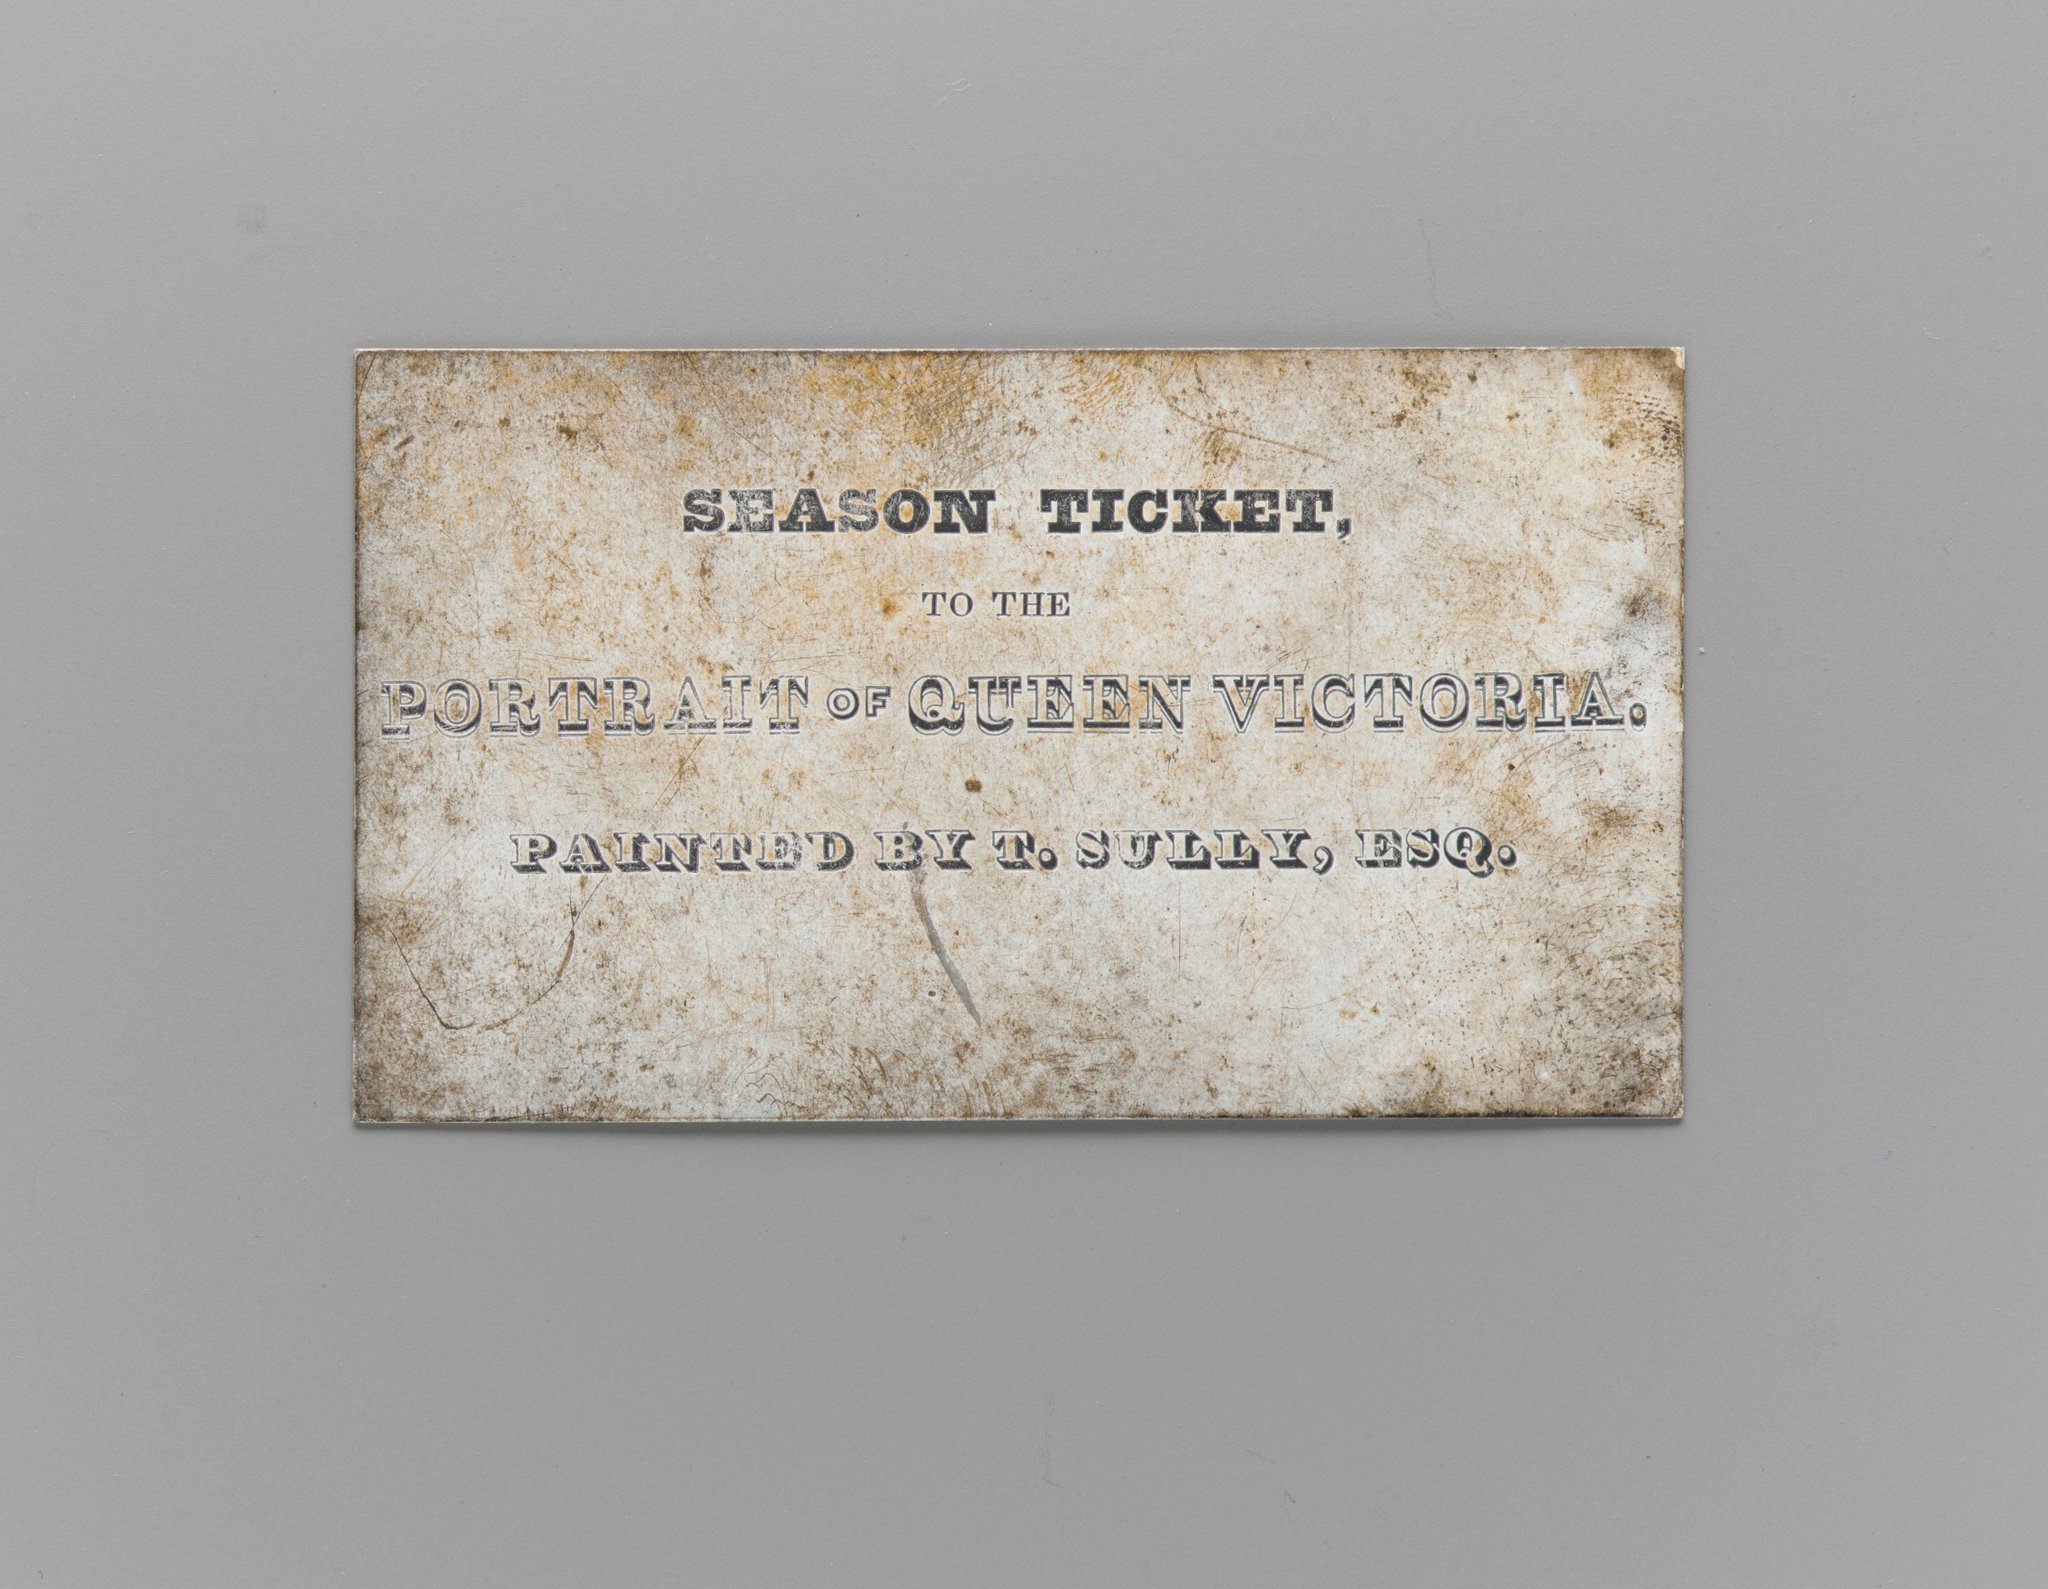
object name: print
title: Season Ticket to the Portrait of Queen Victoria by T. Sully, Esq.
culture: american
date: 1838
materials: paper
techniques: engraving